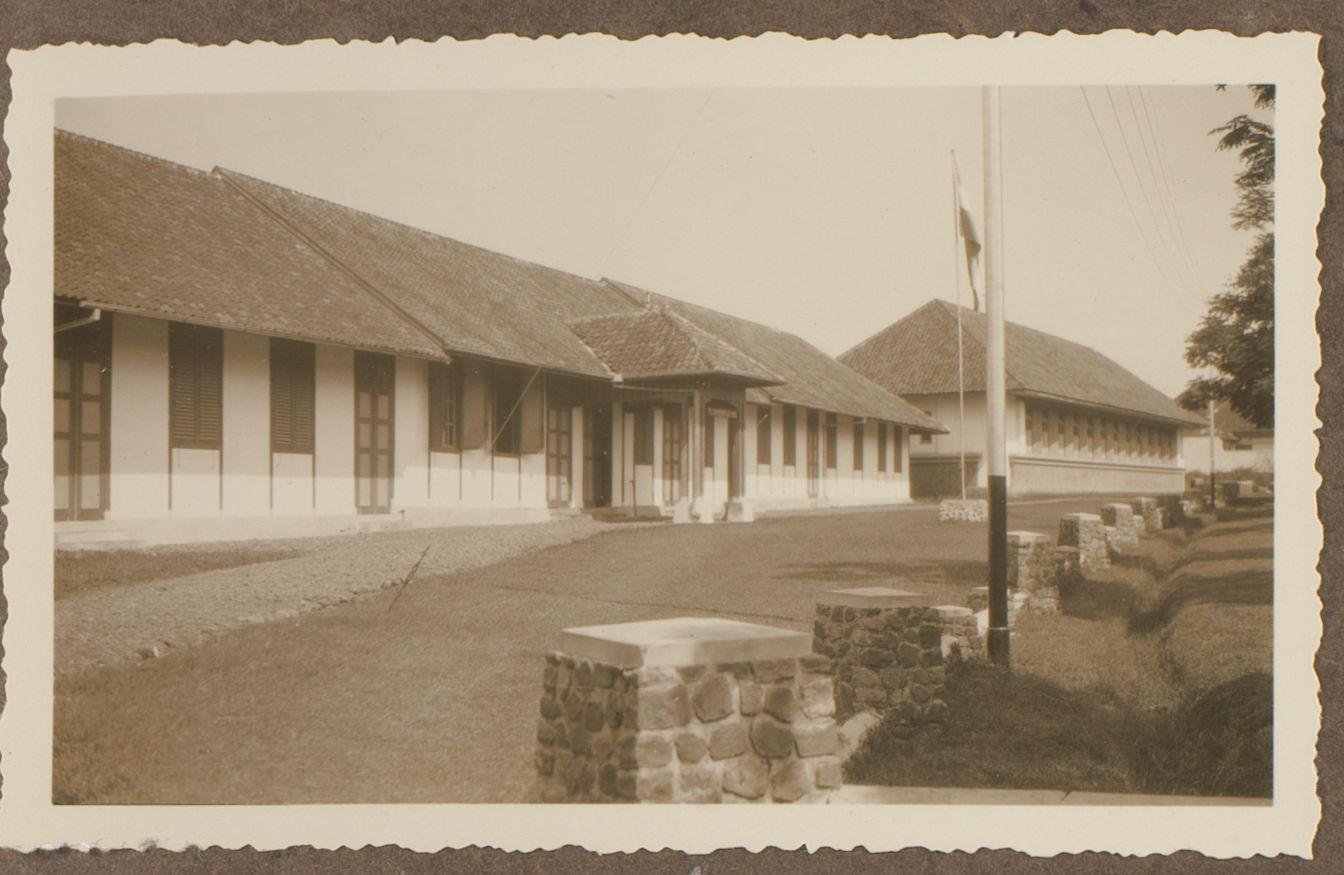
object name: photograph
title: Frontgebouwen van de Technische School te Bandoeng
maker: Anonymous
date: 1933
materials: photographic support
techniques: gelatin silver print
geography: bandung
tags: vocational education, e.g.: junior technical school (+ building ~ education, tuition), colonial government, dutch east indies, the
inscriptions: inscription: ‘Frontgebouwen / TS’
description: Frontgebouwen van de Technische School te Bandoeng. Foto ingeplakt in het fotoalbum aangeboden aan J.H.A. van der Hoeven bij het beëindigen op 31 juli 1933 van zijn diensttijd bij het Nijverheidsonderwijs in Nederlandsch-Indië.